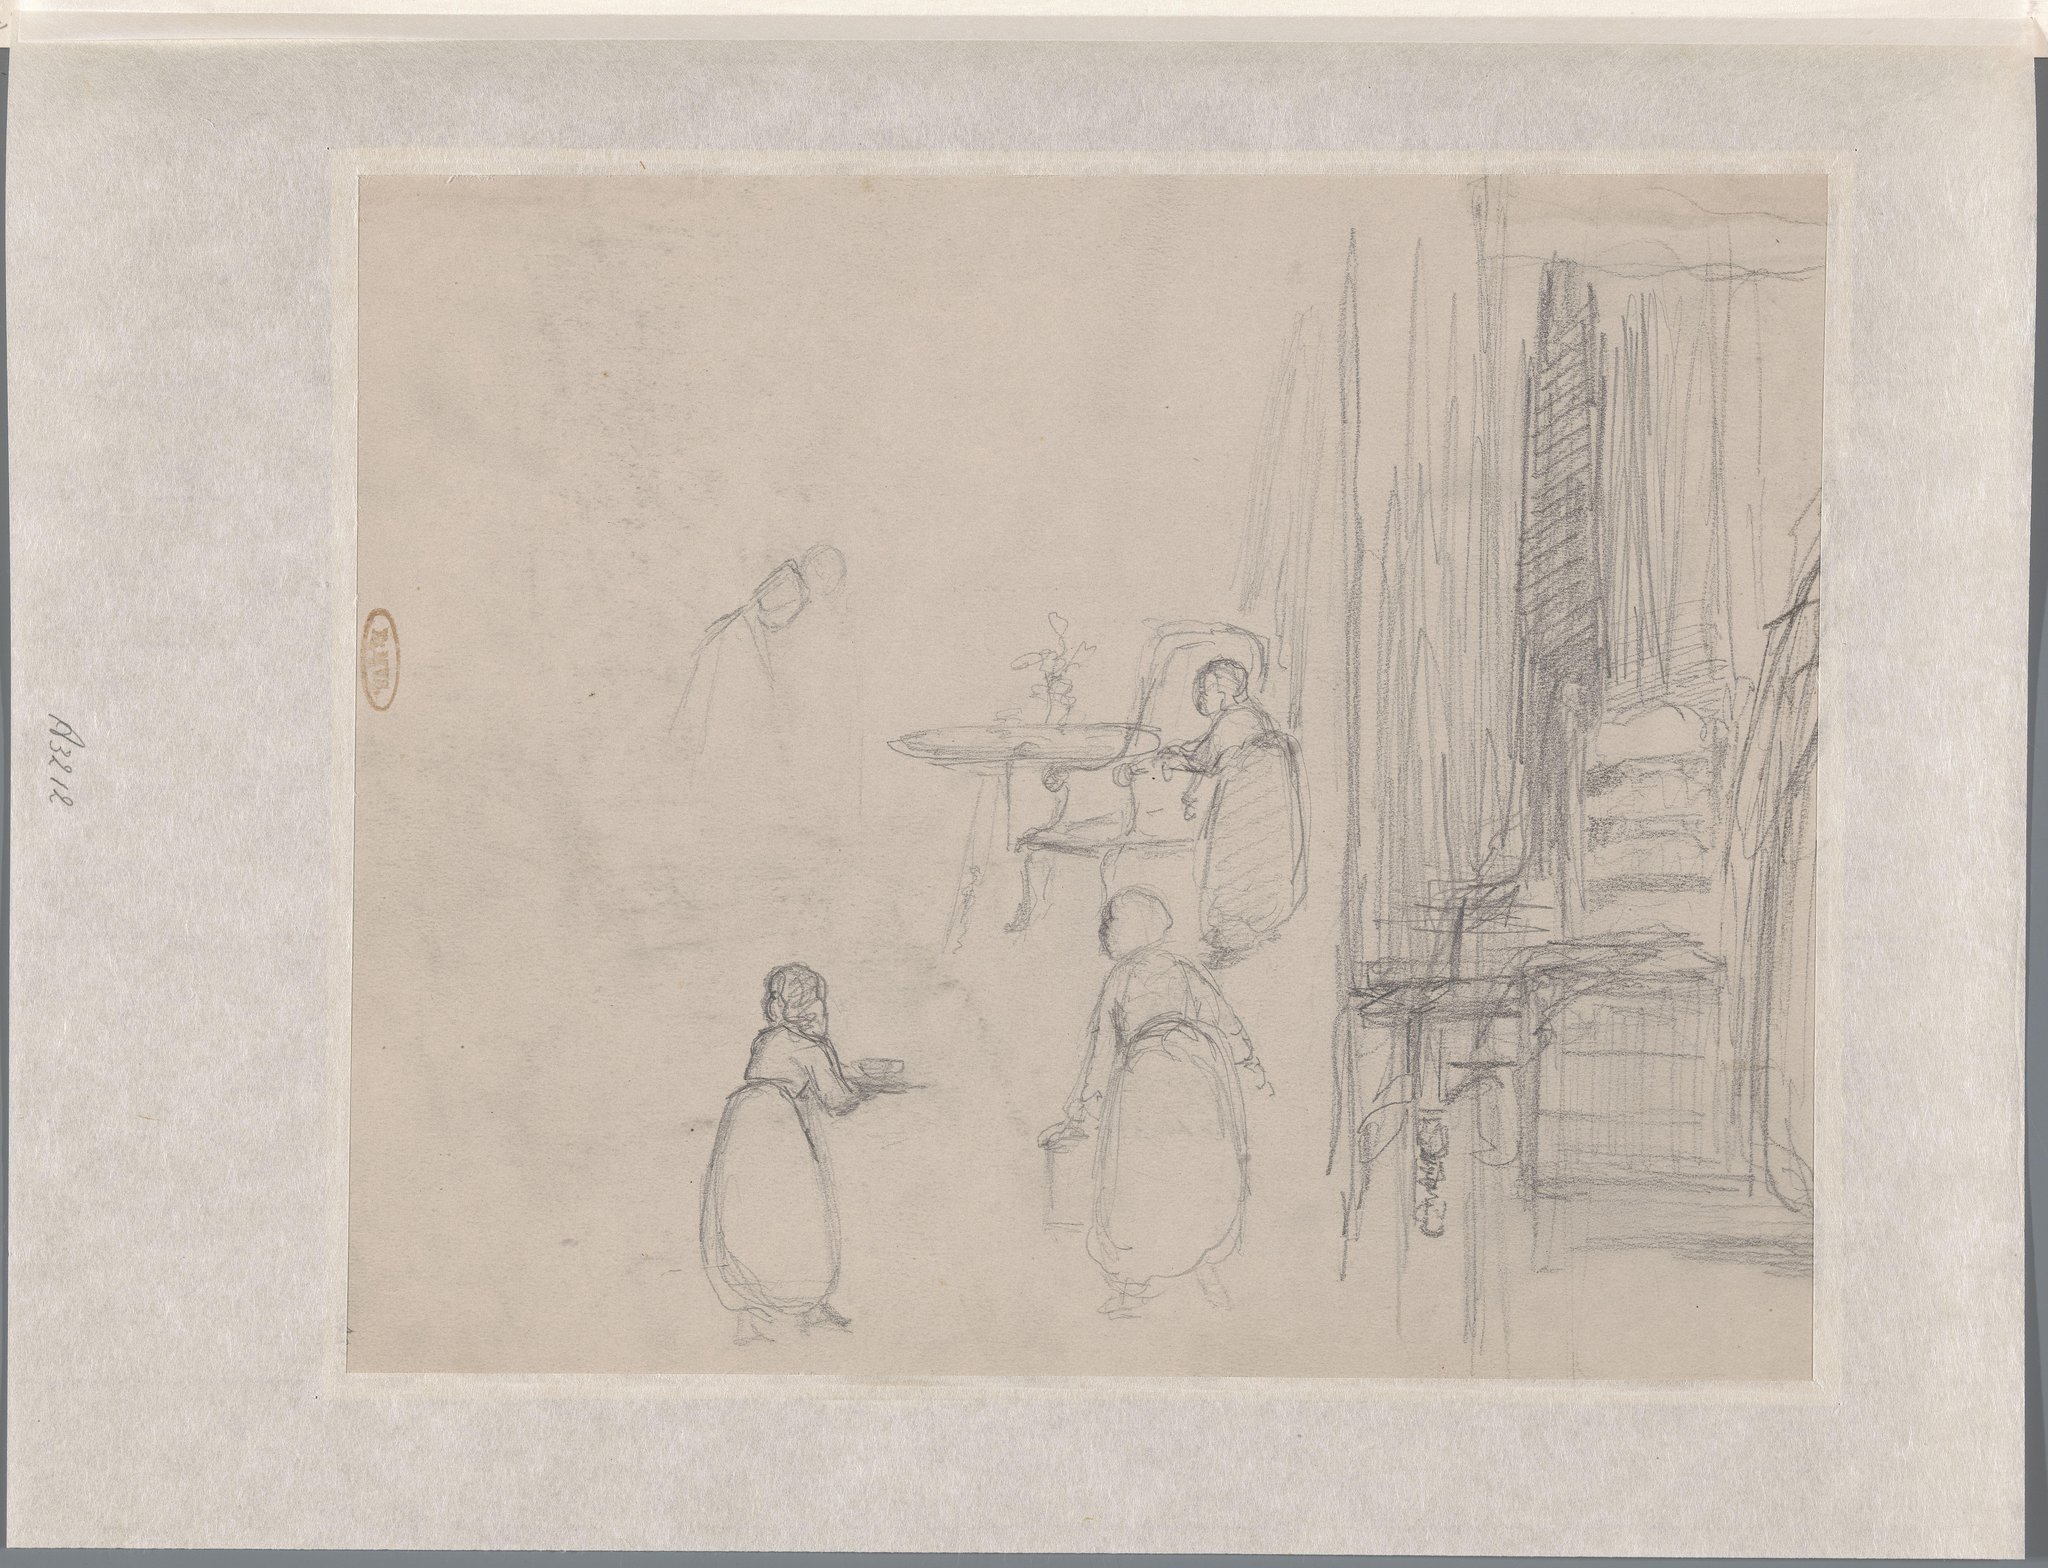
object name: drawing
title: Interieur met dienstmeiden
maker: hendrik valkenburg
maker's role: draughtsman, painter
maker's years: 1826-1896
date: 1836-1896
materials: paper, pencil